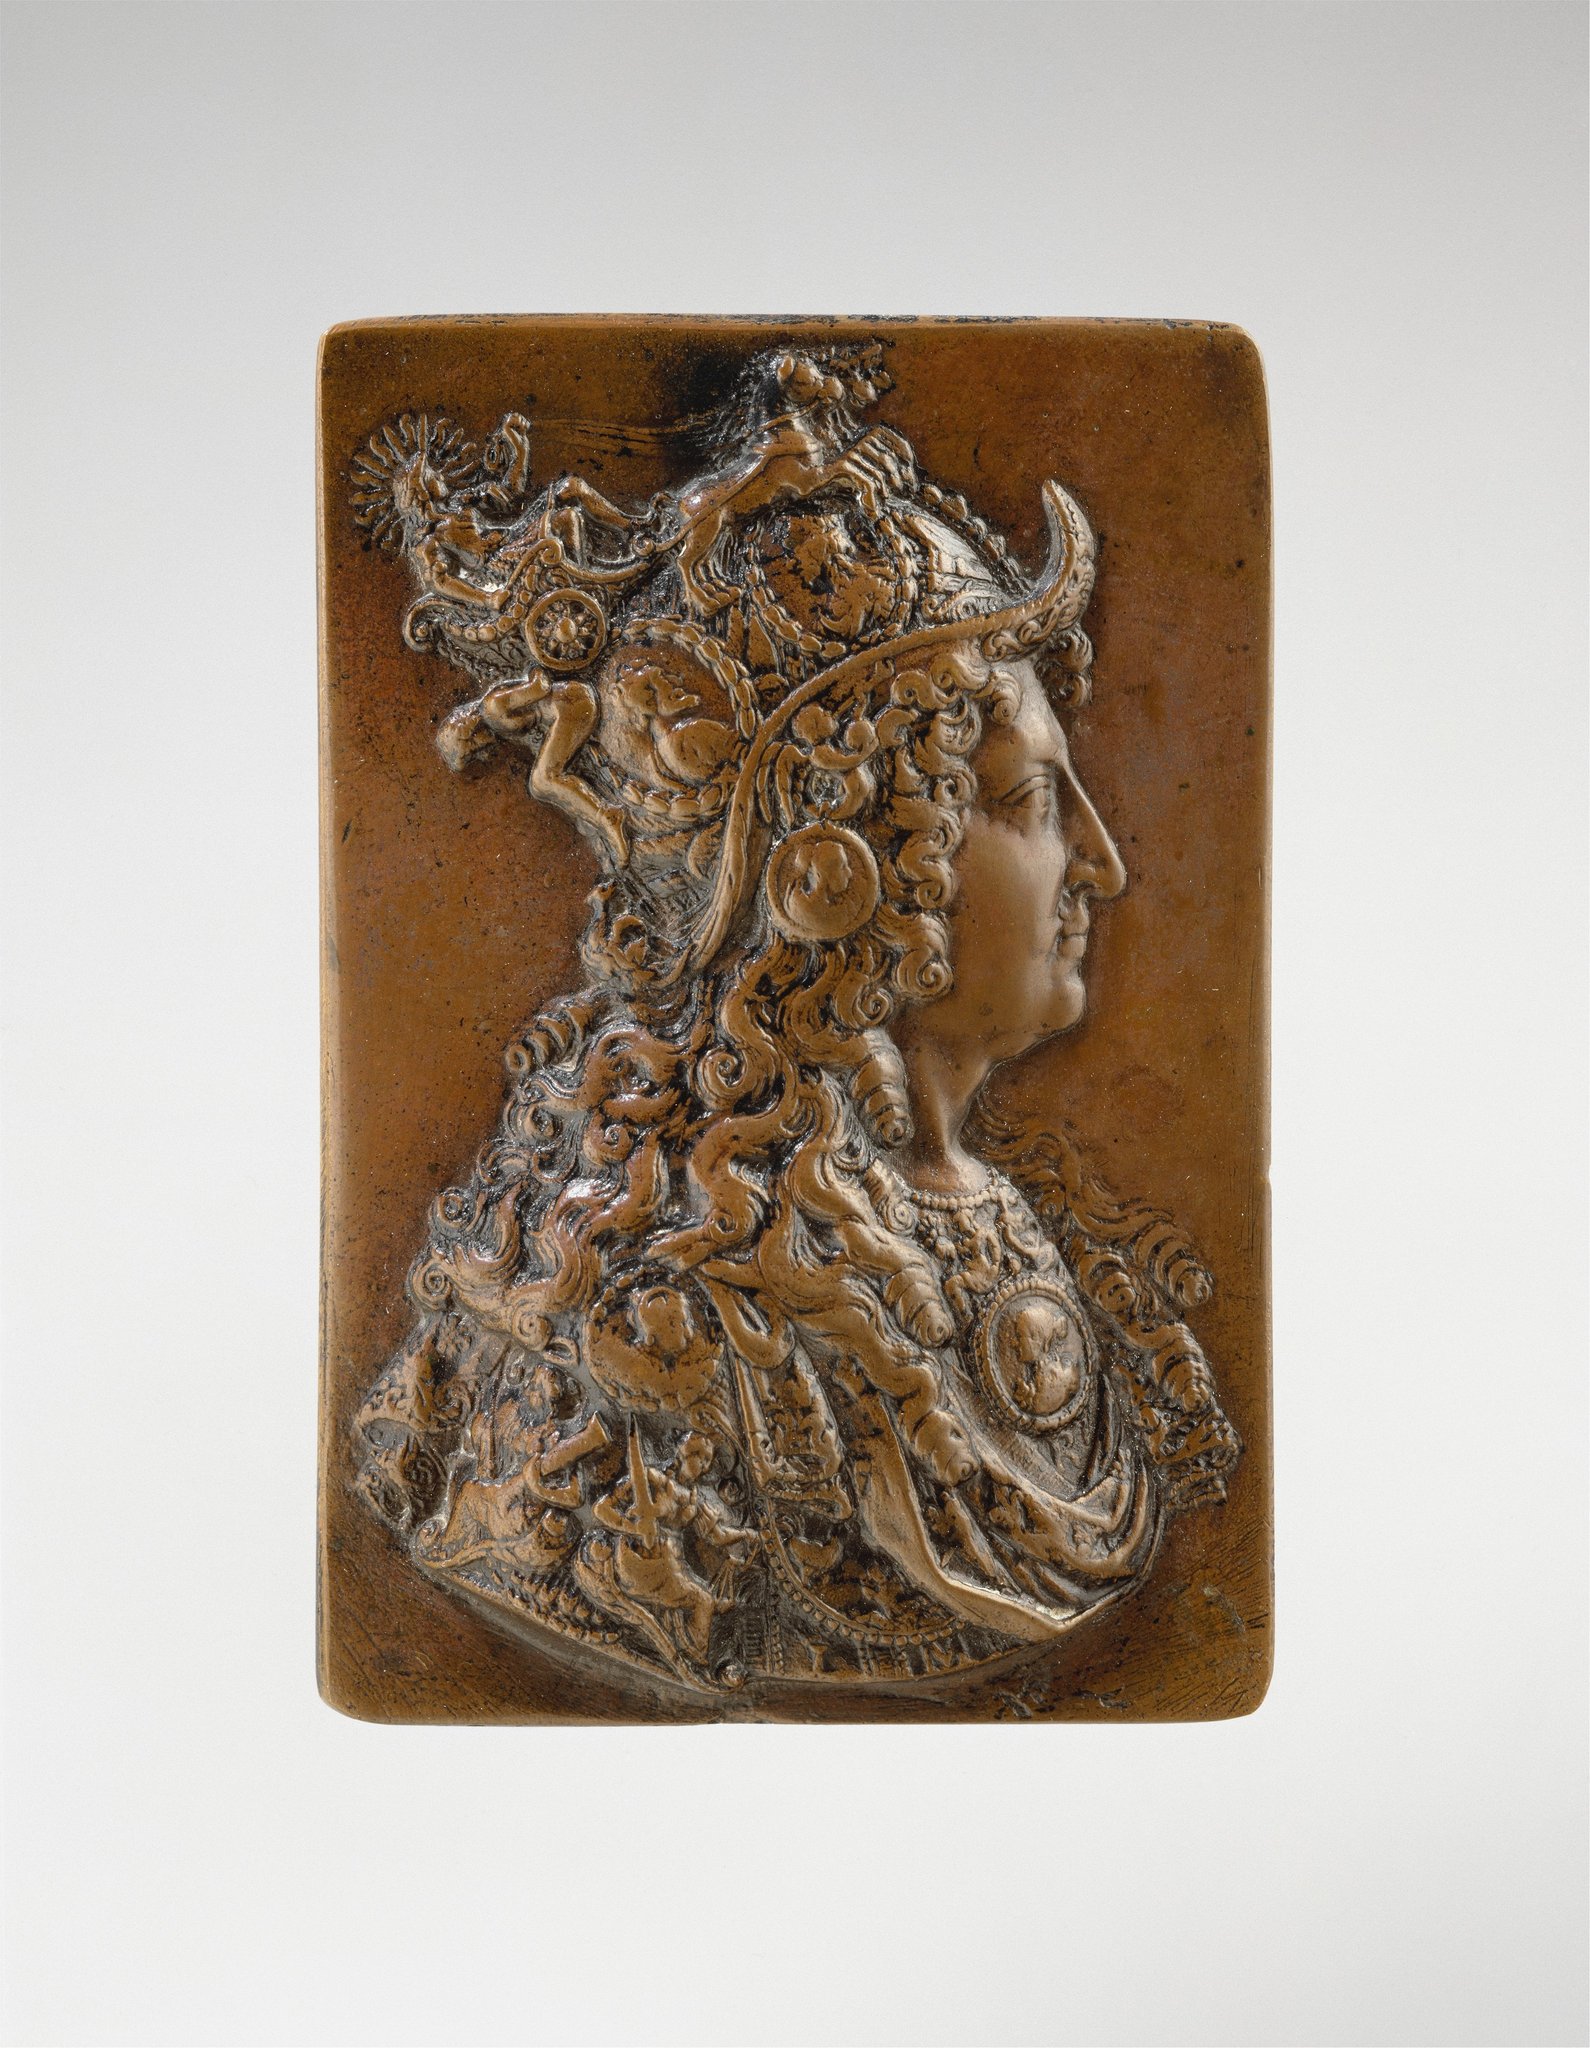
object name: medal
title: Louis XIV in allegorical armor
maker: michel molart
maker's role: artist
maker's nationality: french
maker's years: 1641-1713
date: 1601-1700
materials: bronze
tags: helmets,louis xiv,men,profiles,chariots